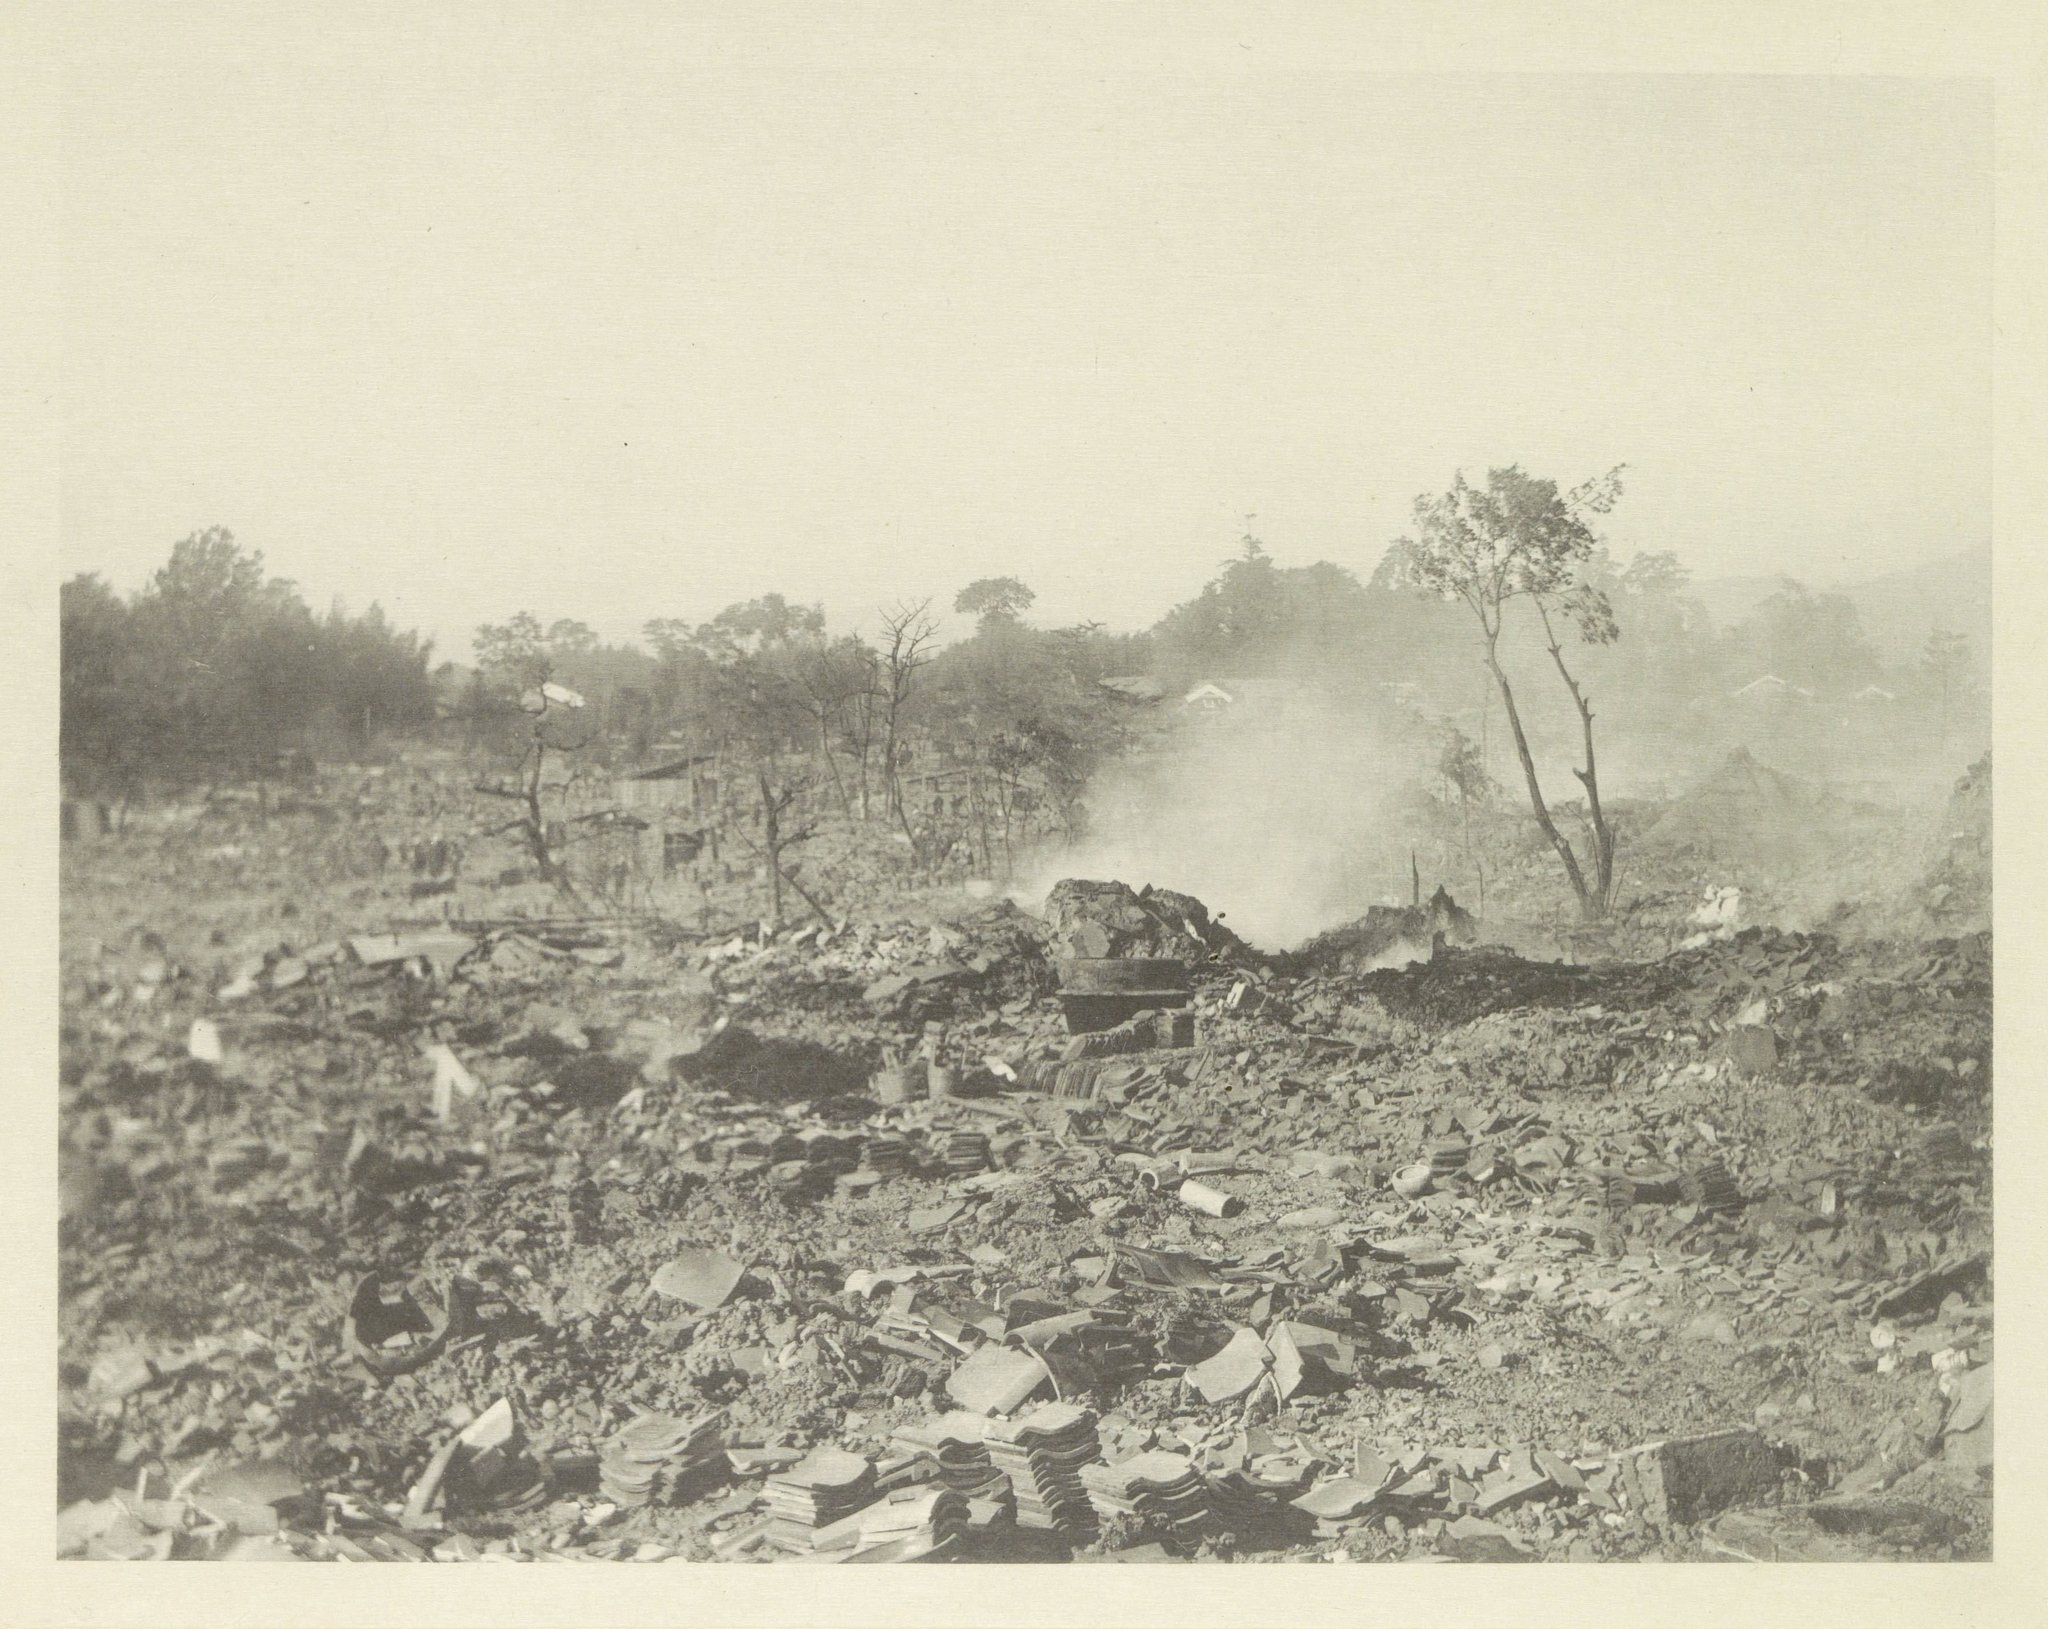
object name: photomechanical print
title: Verwoeste gebouwen te Kasamatsu na een aardbeving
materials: paper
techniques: photograph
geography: kasamatsu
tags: ruin of a building ~ architecture, consequences of an earthquake